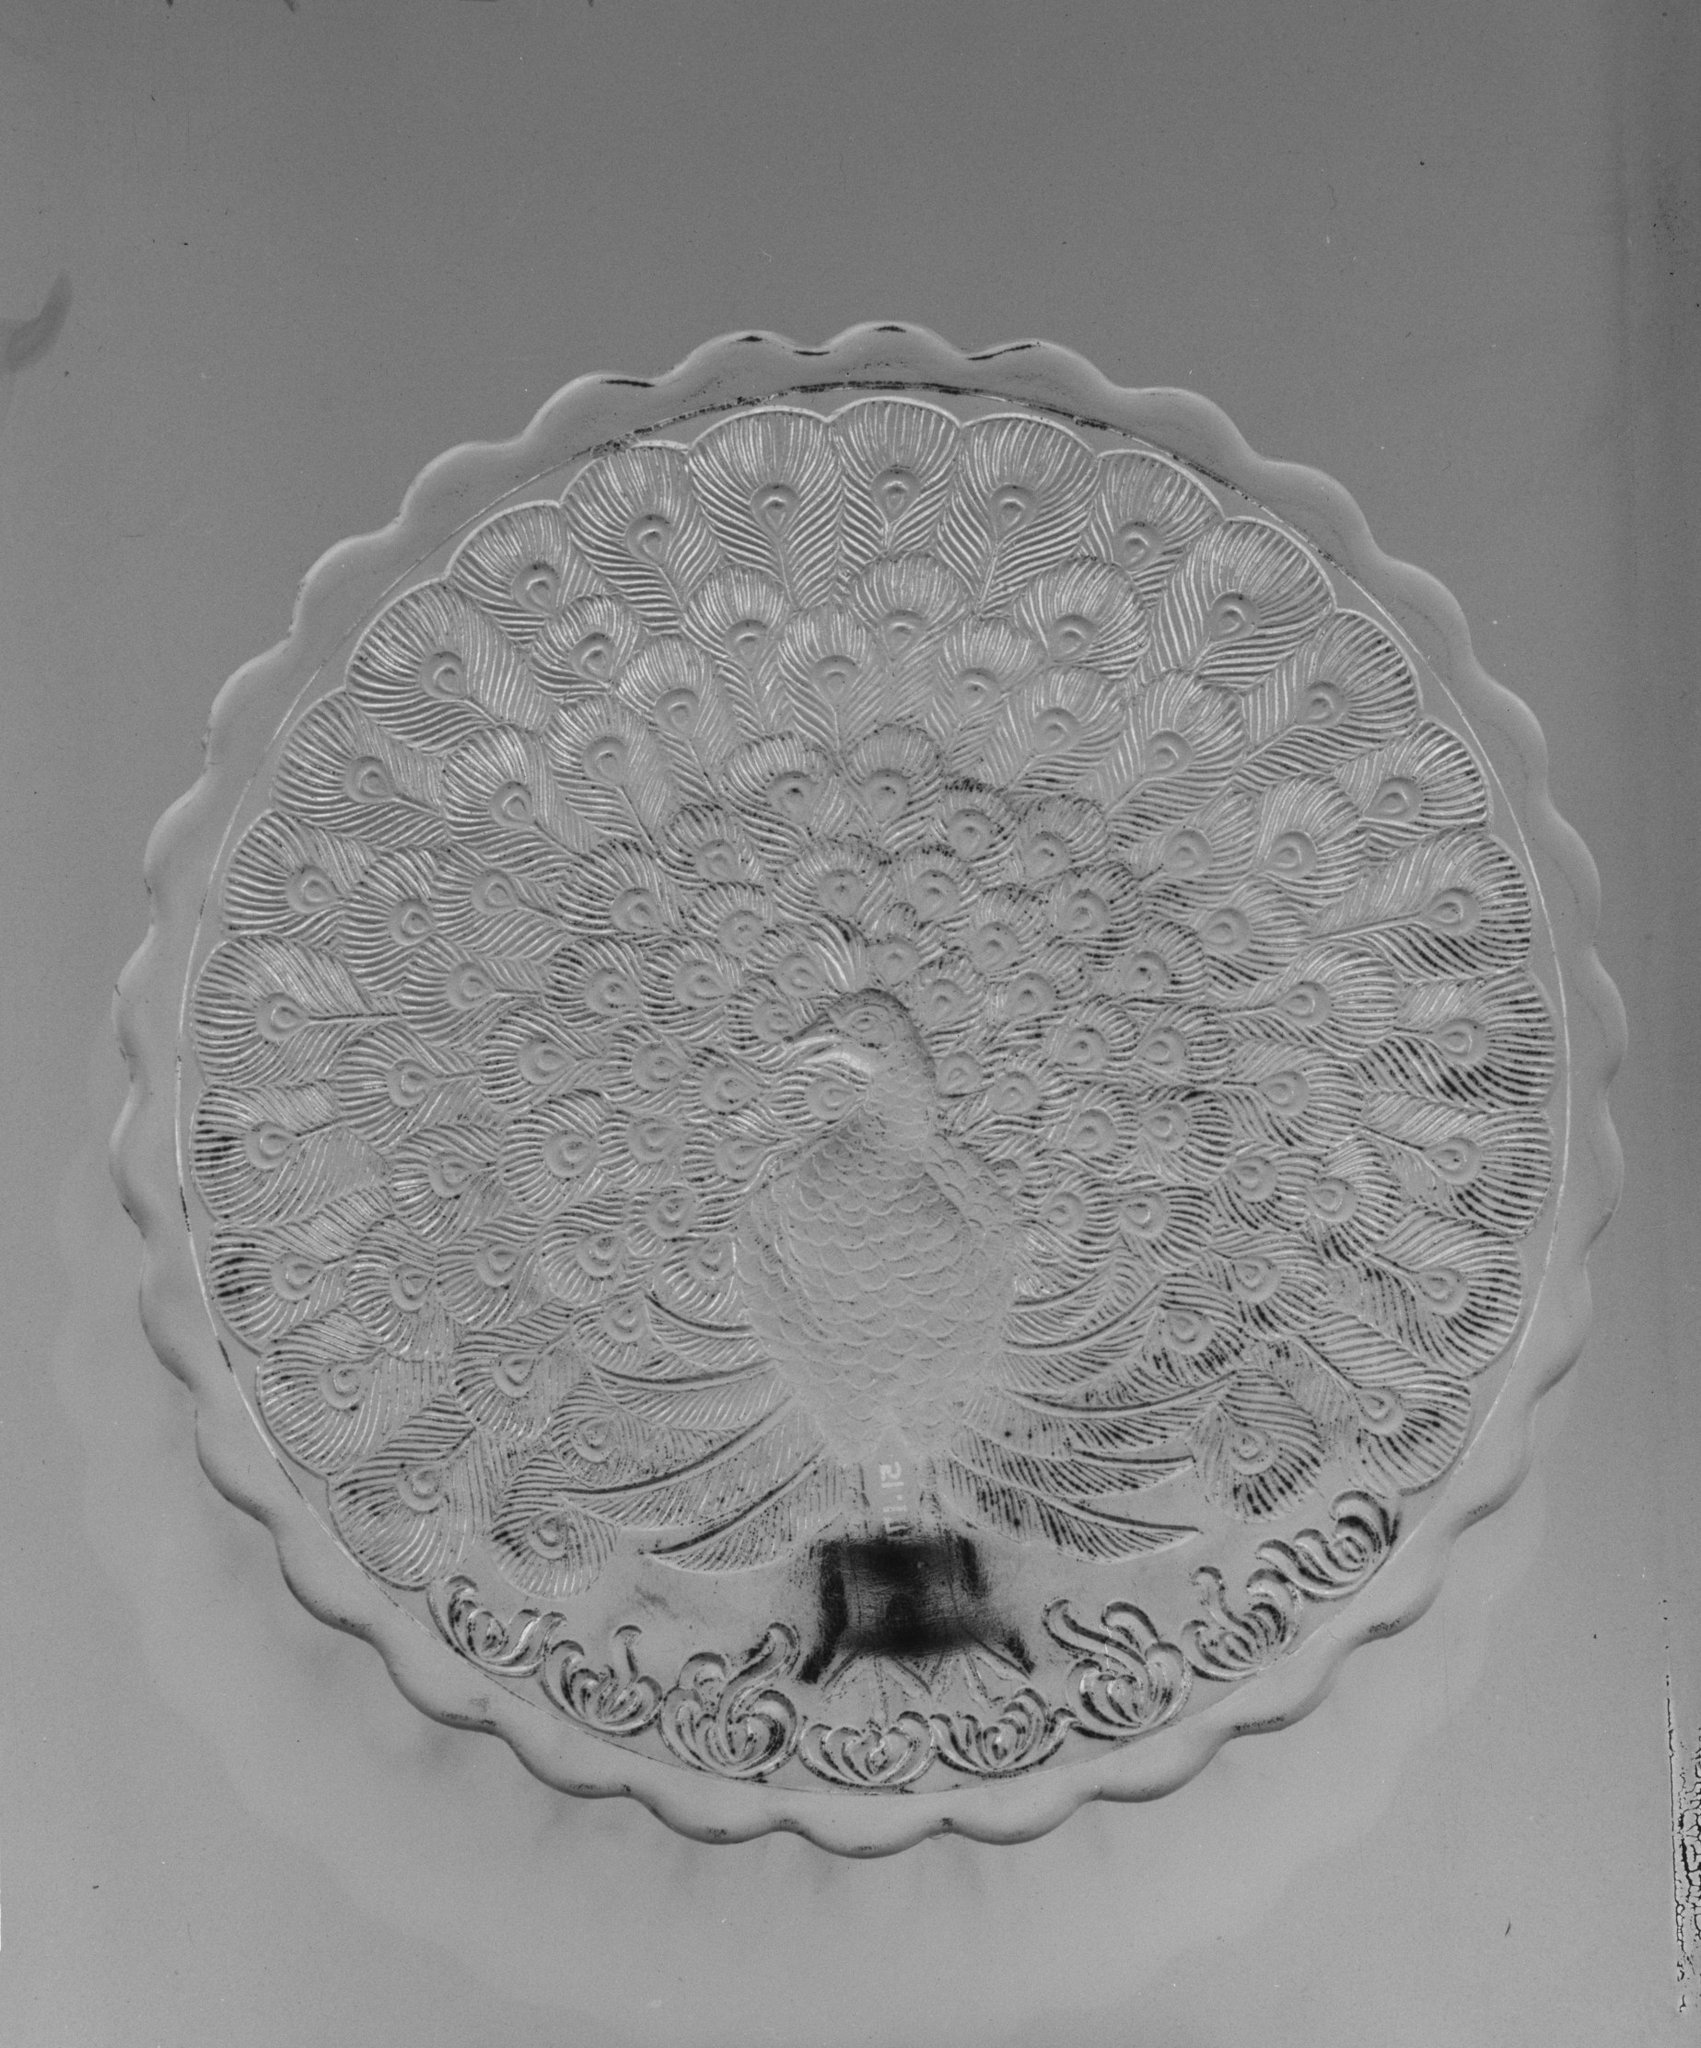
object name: plate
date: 1870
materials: glass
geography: england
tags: peacocks